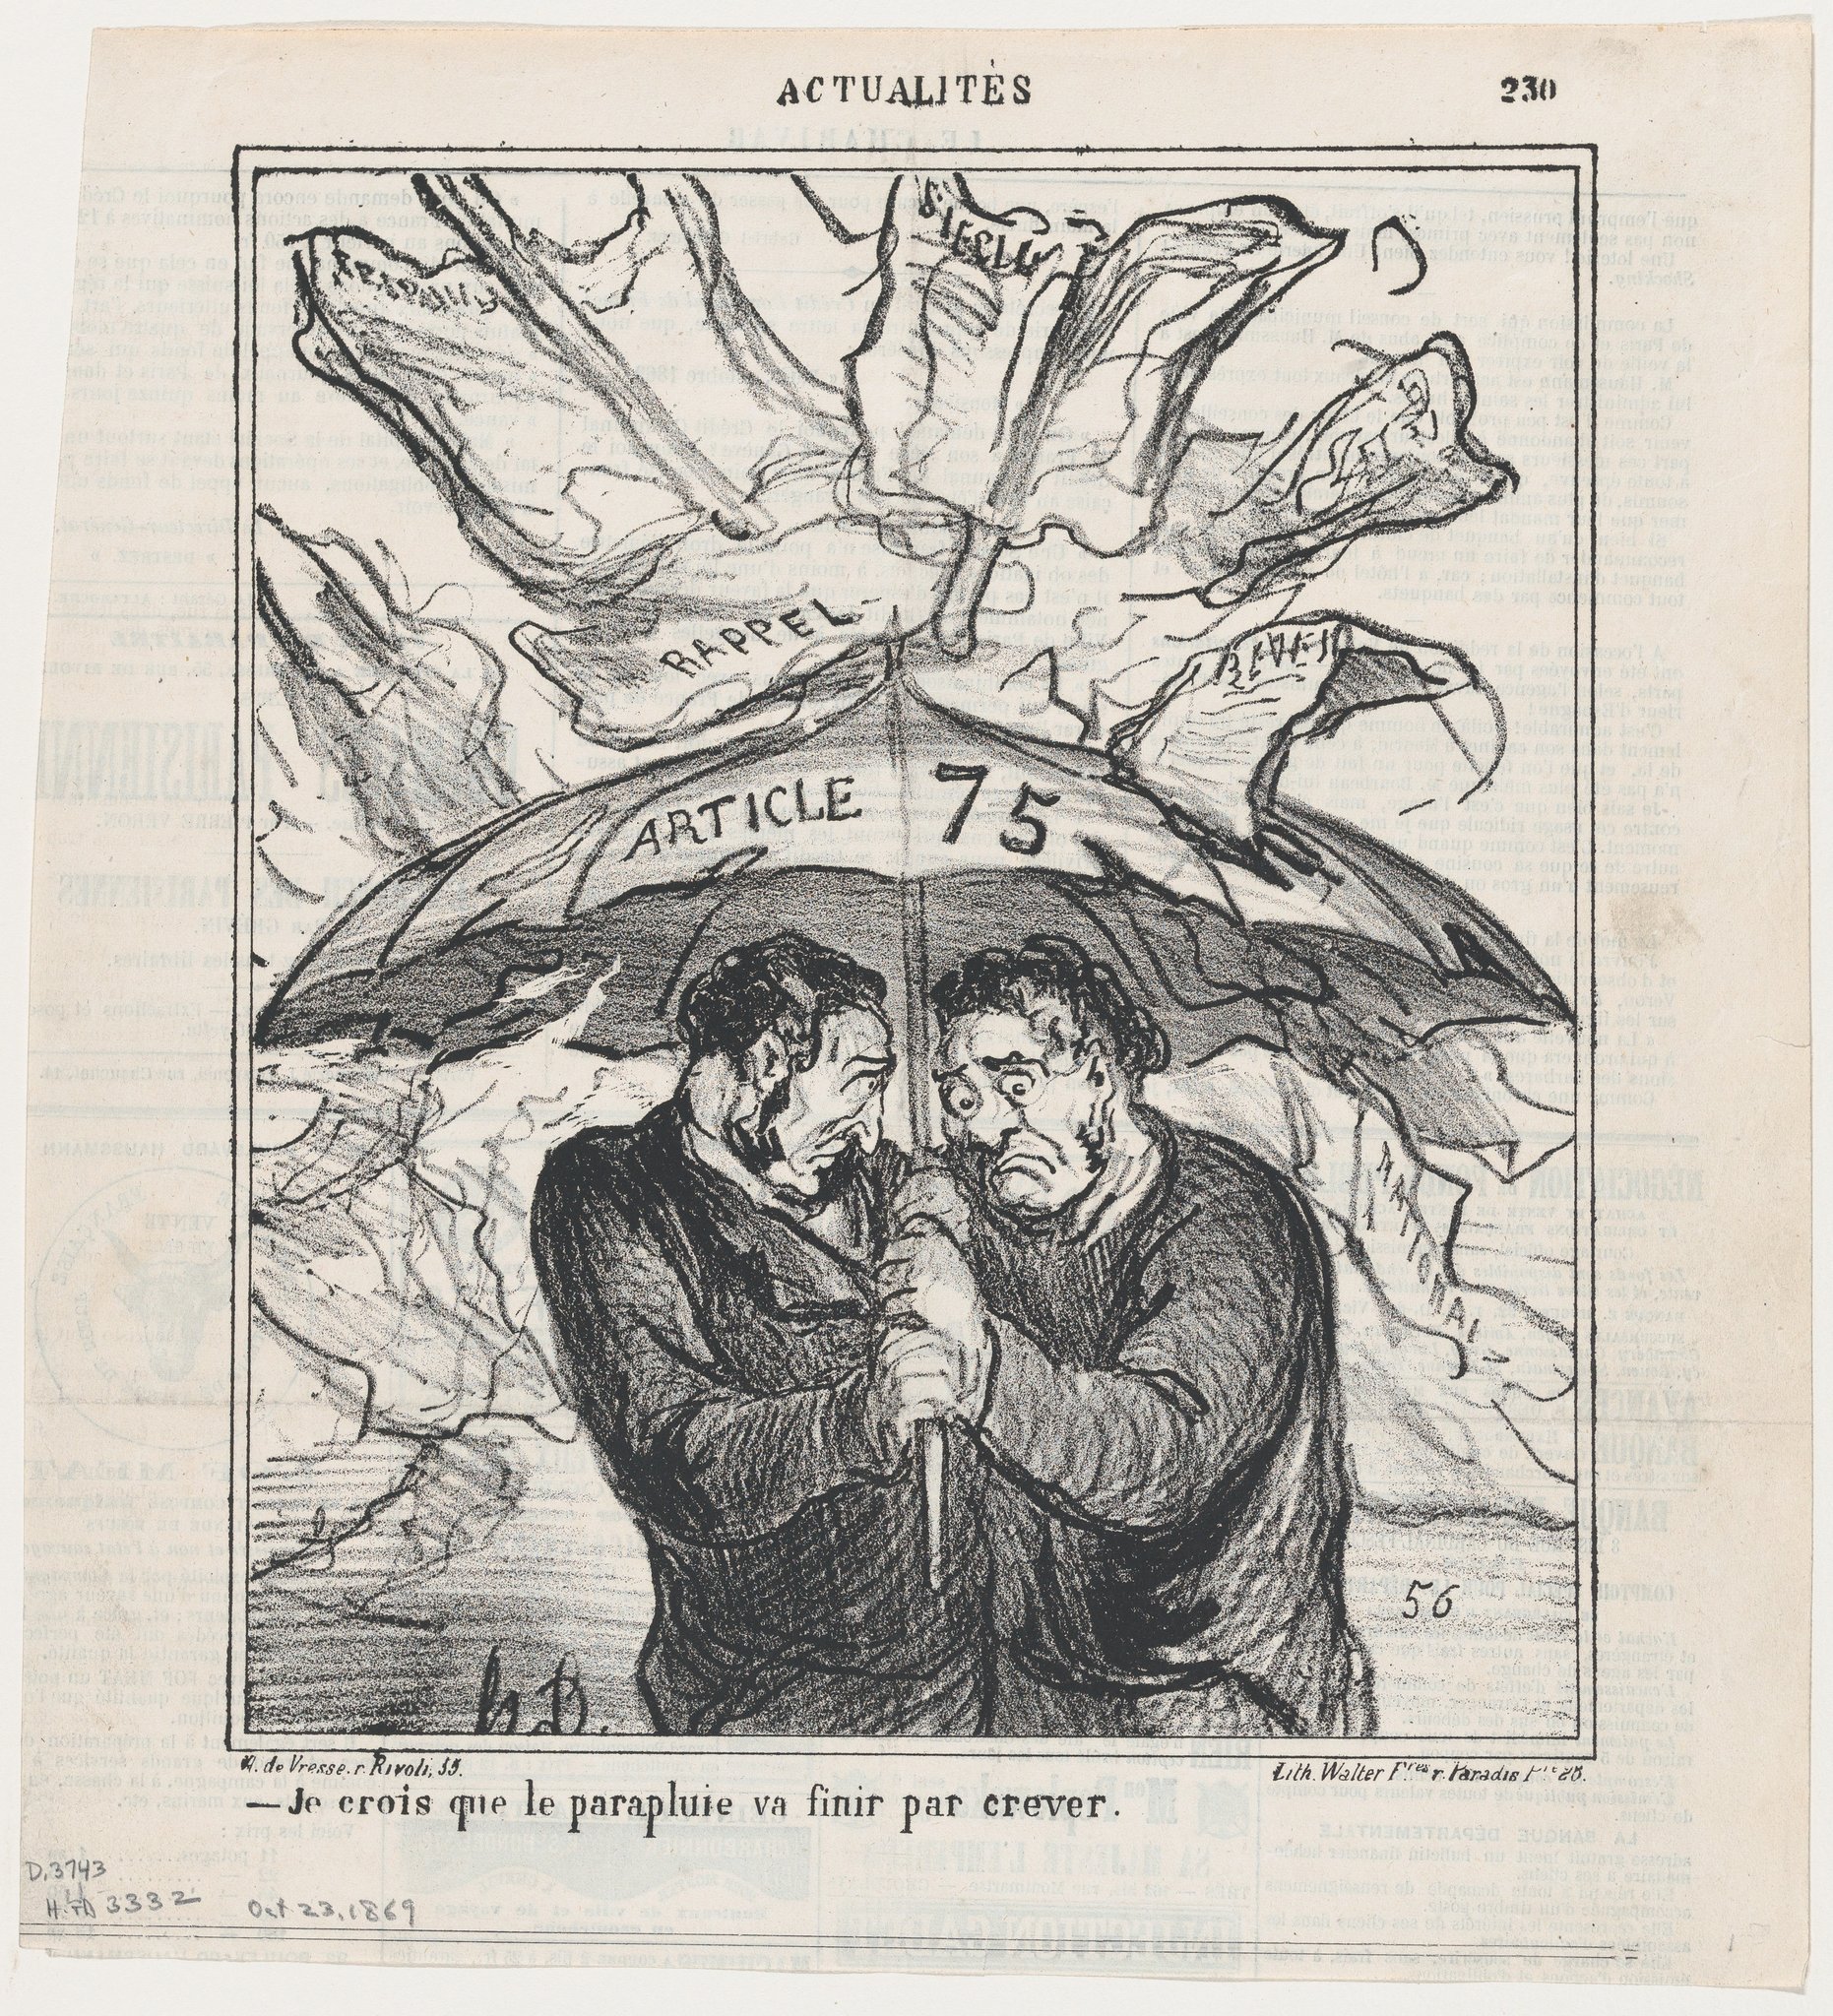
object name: print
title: I think this umbrella is going to collapse pretty soon, from 'News of the day,' published in Le Charivari, October 23, 1869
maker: honoré daumier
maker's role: artist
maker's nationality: french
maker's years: 1808-1879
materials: paper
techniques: lithograph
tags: satire,fear,men